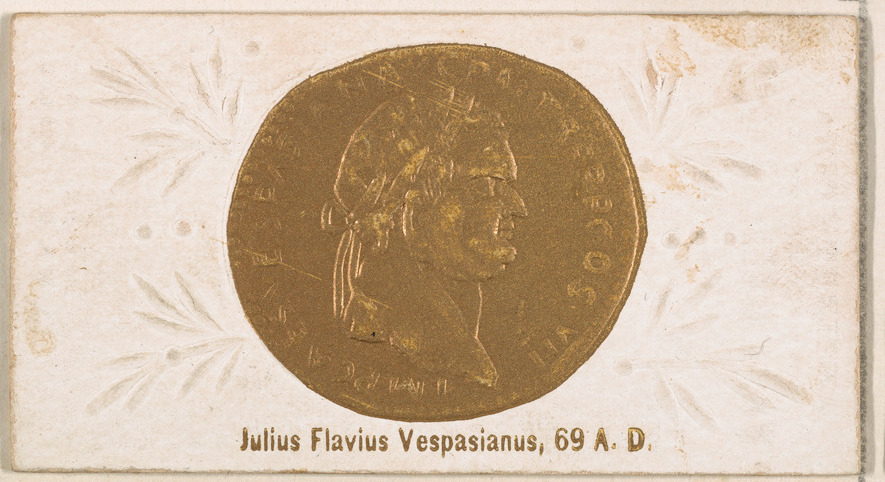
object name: print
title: Julius Flavius Vespasianus, 69 A.D., from the Ancient Coins series (N180) issued by Wm. S. Kimball & Co.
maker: william s. kimball & company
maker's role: publisher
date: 1888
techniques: color lithograph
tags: men,coins